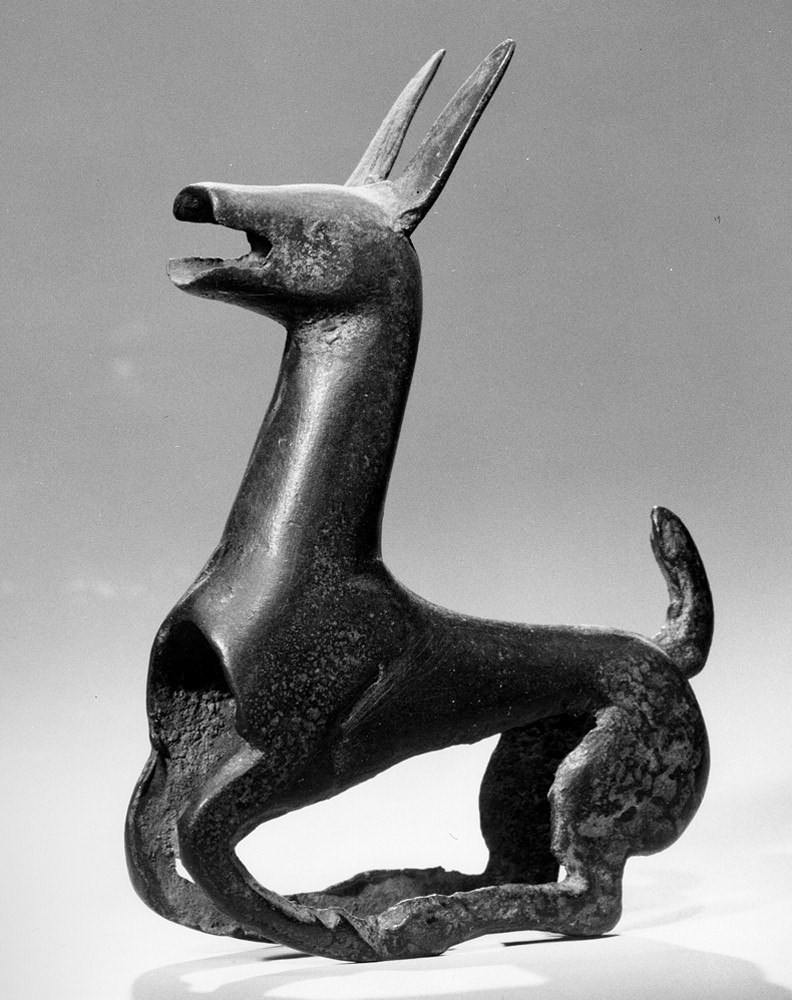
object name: yoke ornament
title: Yoke ornament in the shape of a deer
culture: chinese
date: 500-301 BCE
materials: bronze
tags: deer